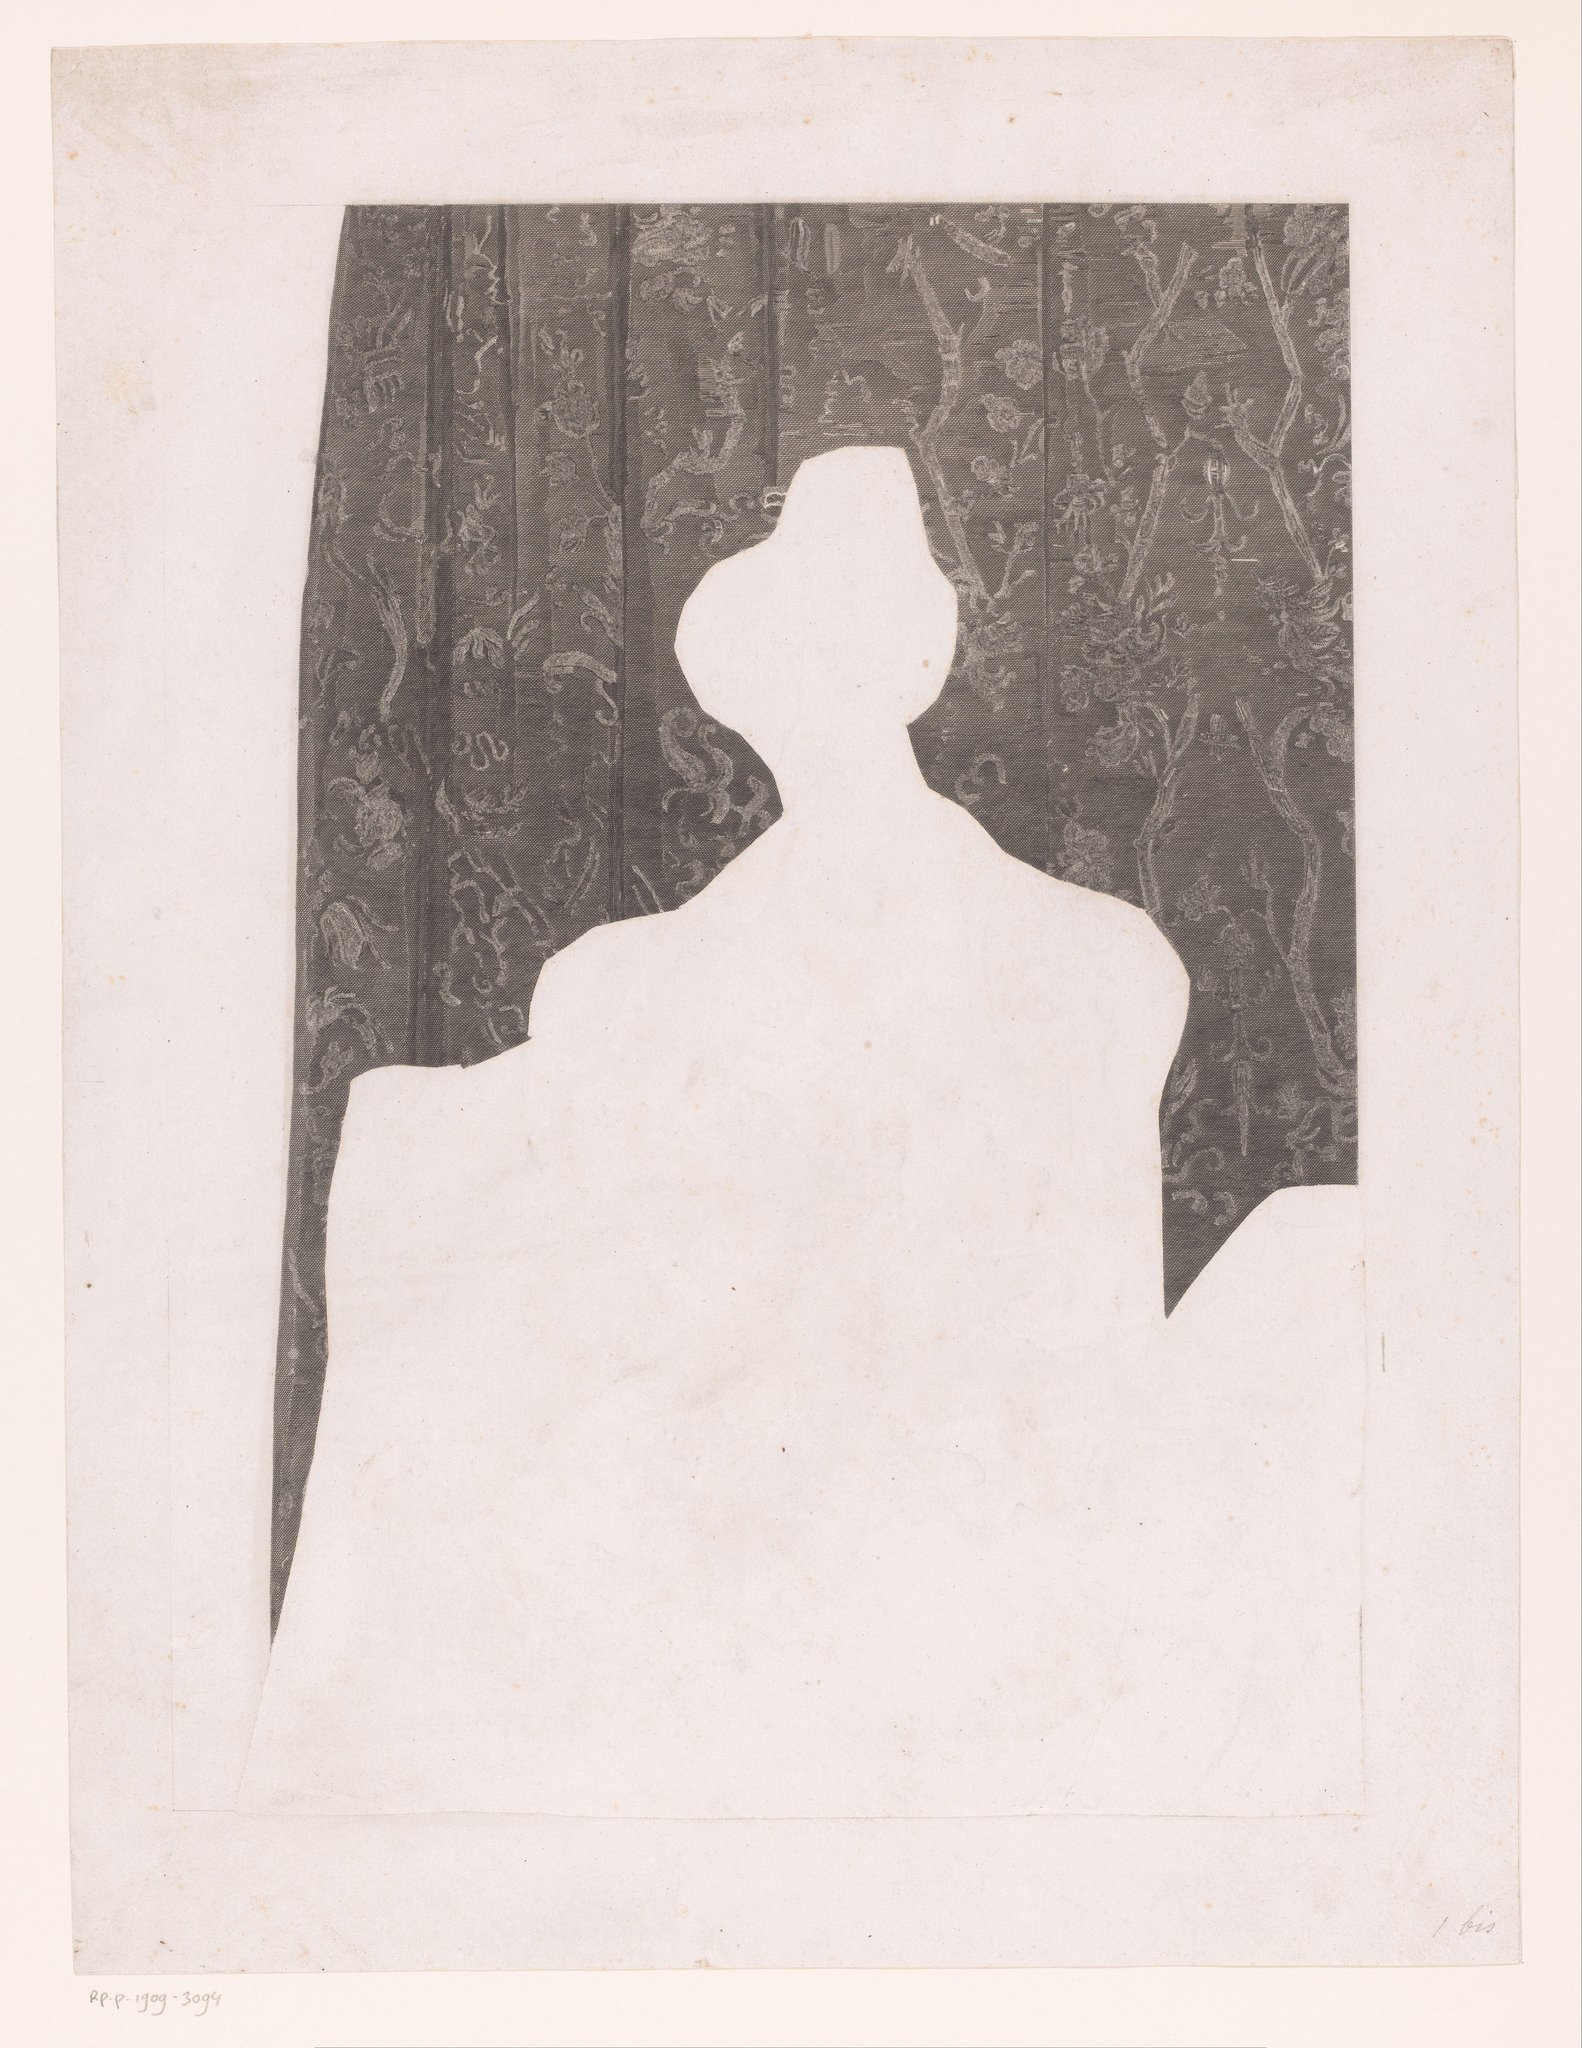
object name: print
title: Draperie met florale motieven met uitgespaard portret van Louise Marie van Orléans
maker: erin corr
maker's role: draughtsman, print maker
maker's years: 1805-1862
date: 1832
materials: paper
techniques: engraving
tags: louise marie van orléans (koningin van belgië), curtains, historical persons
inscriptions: collector's mark: Lugt 2228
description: De plaat is bij deze afdruk waarschijnlijk deels afgedekt, waardoor het portret is uitgespaard (zie RP-P-1909-3093).